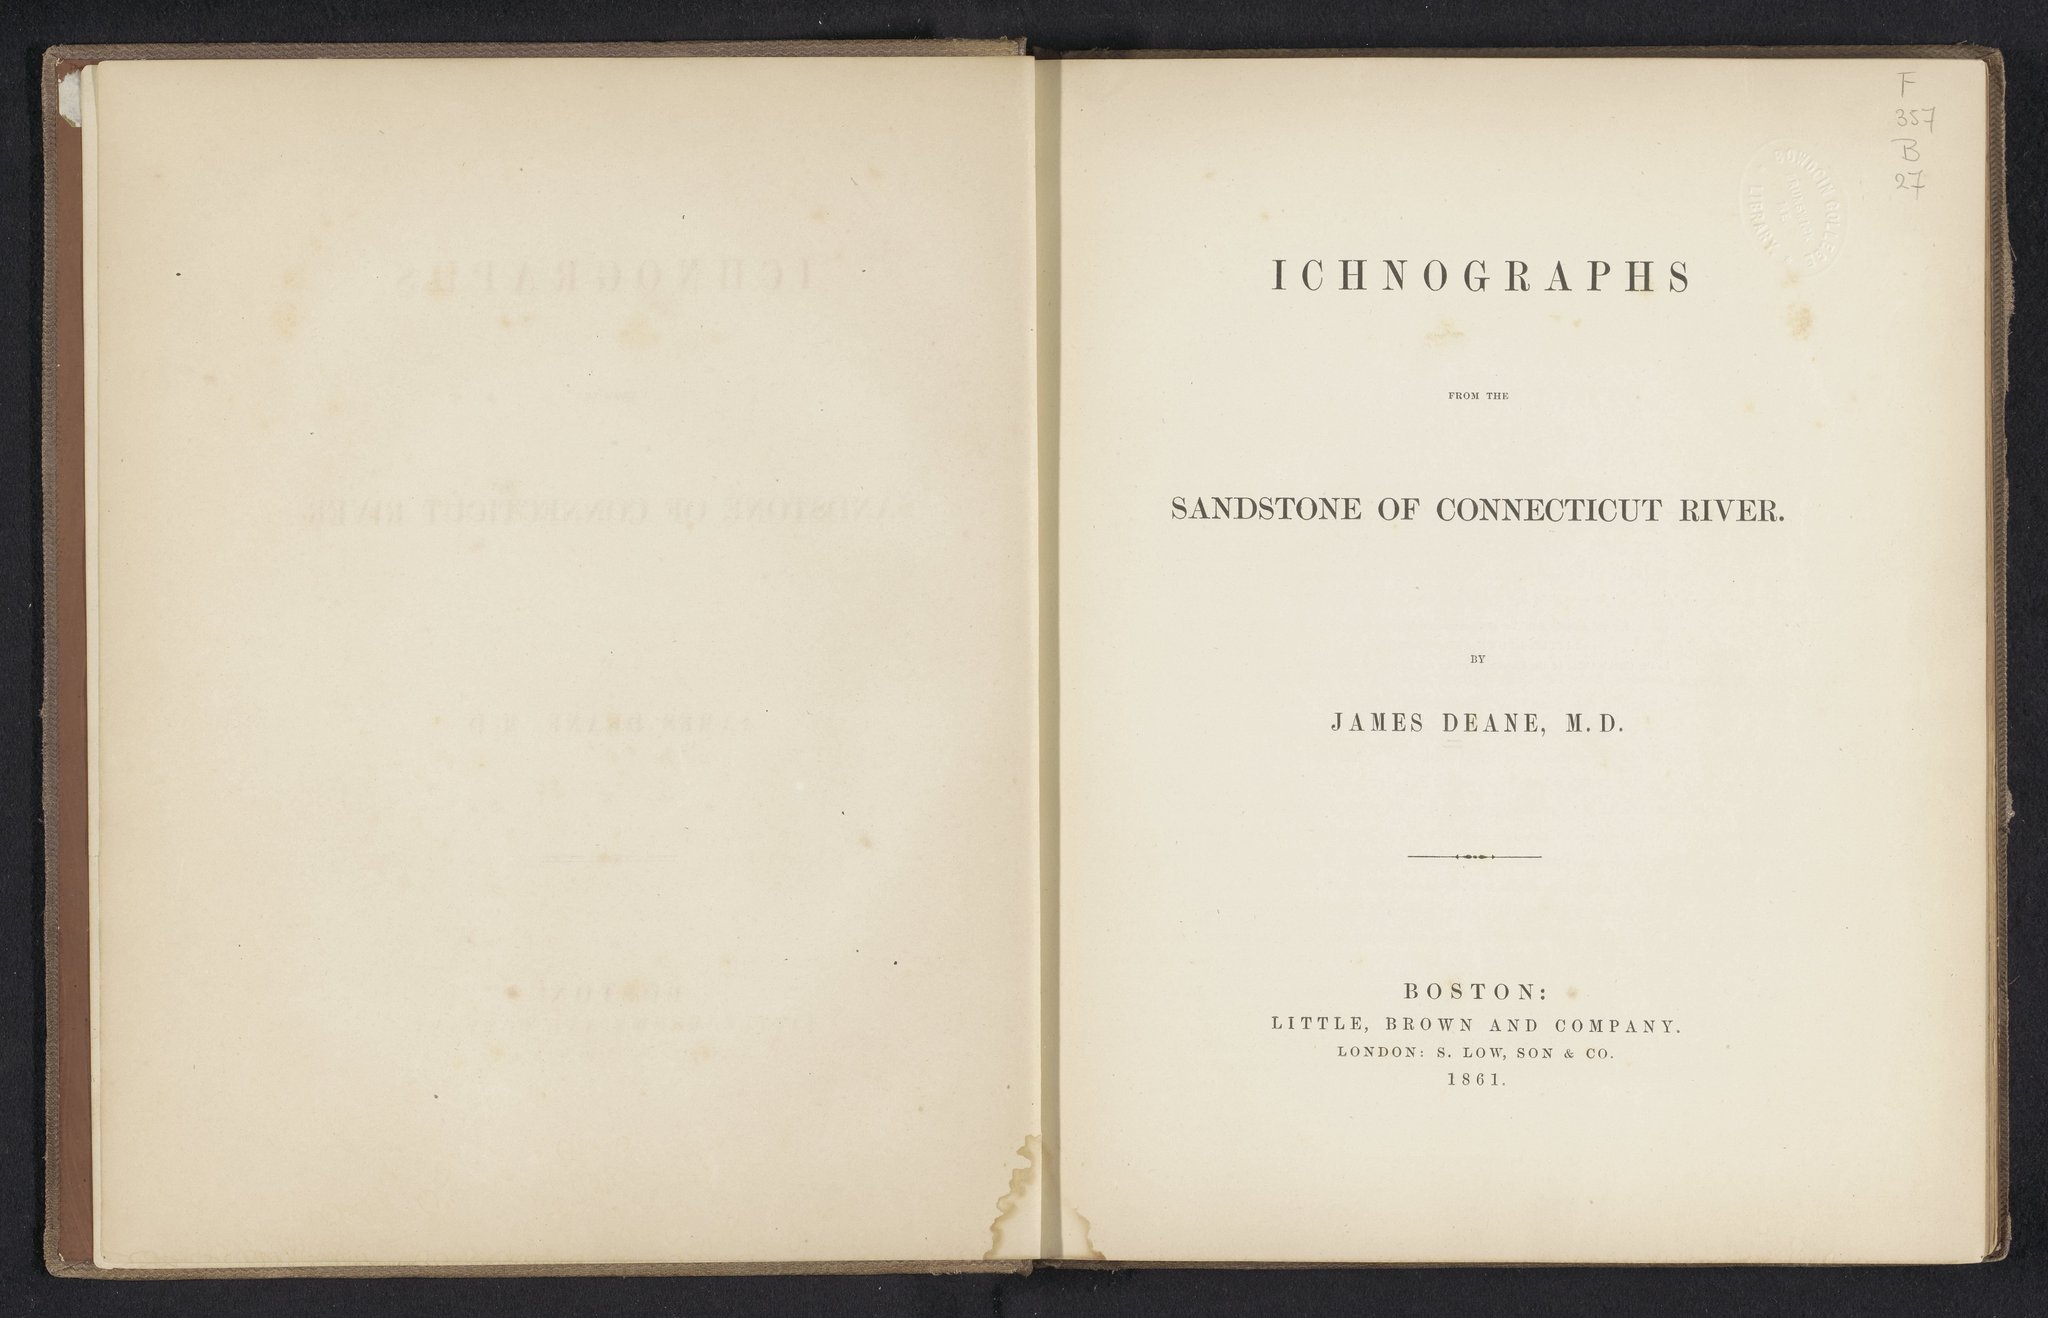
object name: book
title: Ichnographs from the sandstone of Connecticut River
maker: james deane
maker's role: archeoloog, chirurg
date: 1861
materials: cardboard, linen, paper, photographic support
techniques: lithograph, printing, salted paper print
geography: boston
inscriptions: number: ‘104255’, name: ‘Bowdoin College Library The Gift of Miss Alice May Douglas’, name: ‘Bowdoin College Library. Brunswick ME.’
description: In 1835 the American physician Deane became interested in tracks he had found near Greenfield, his place of residence. He suspected that prehistoric birds had made them. He debated the nature of these tracks with an eminent fellow geologist up to his death. Published posthumously in 1861, the book on display includes photographs of fossil footprints, as well as recently fallen raindrops.